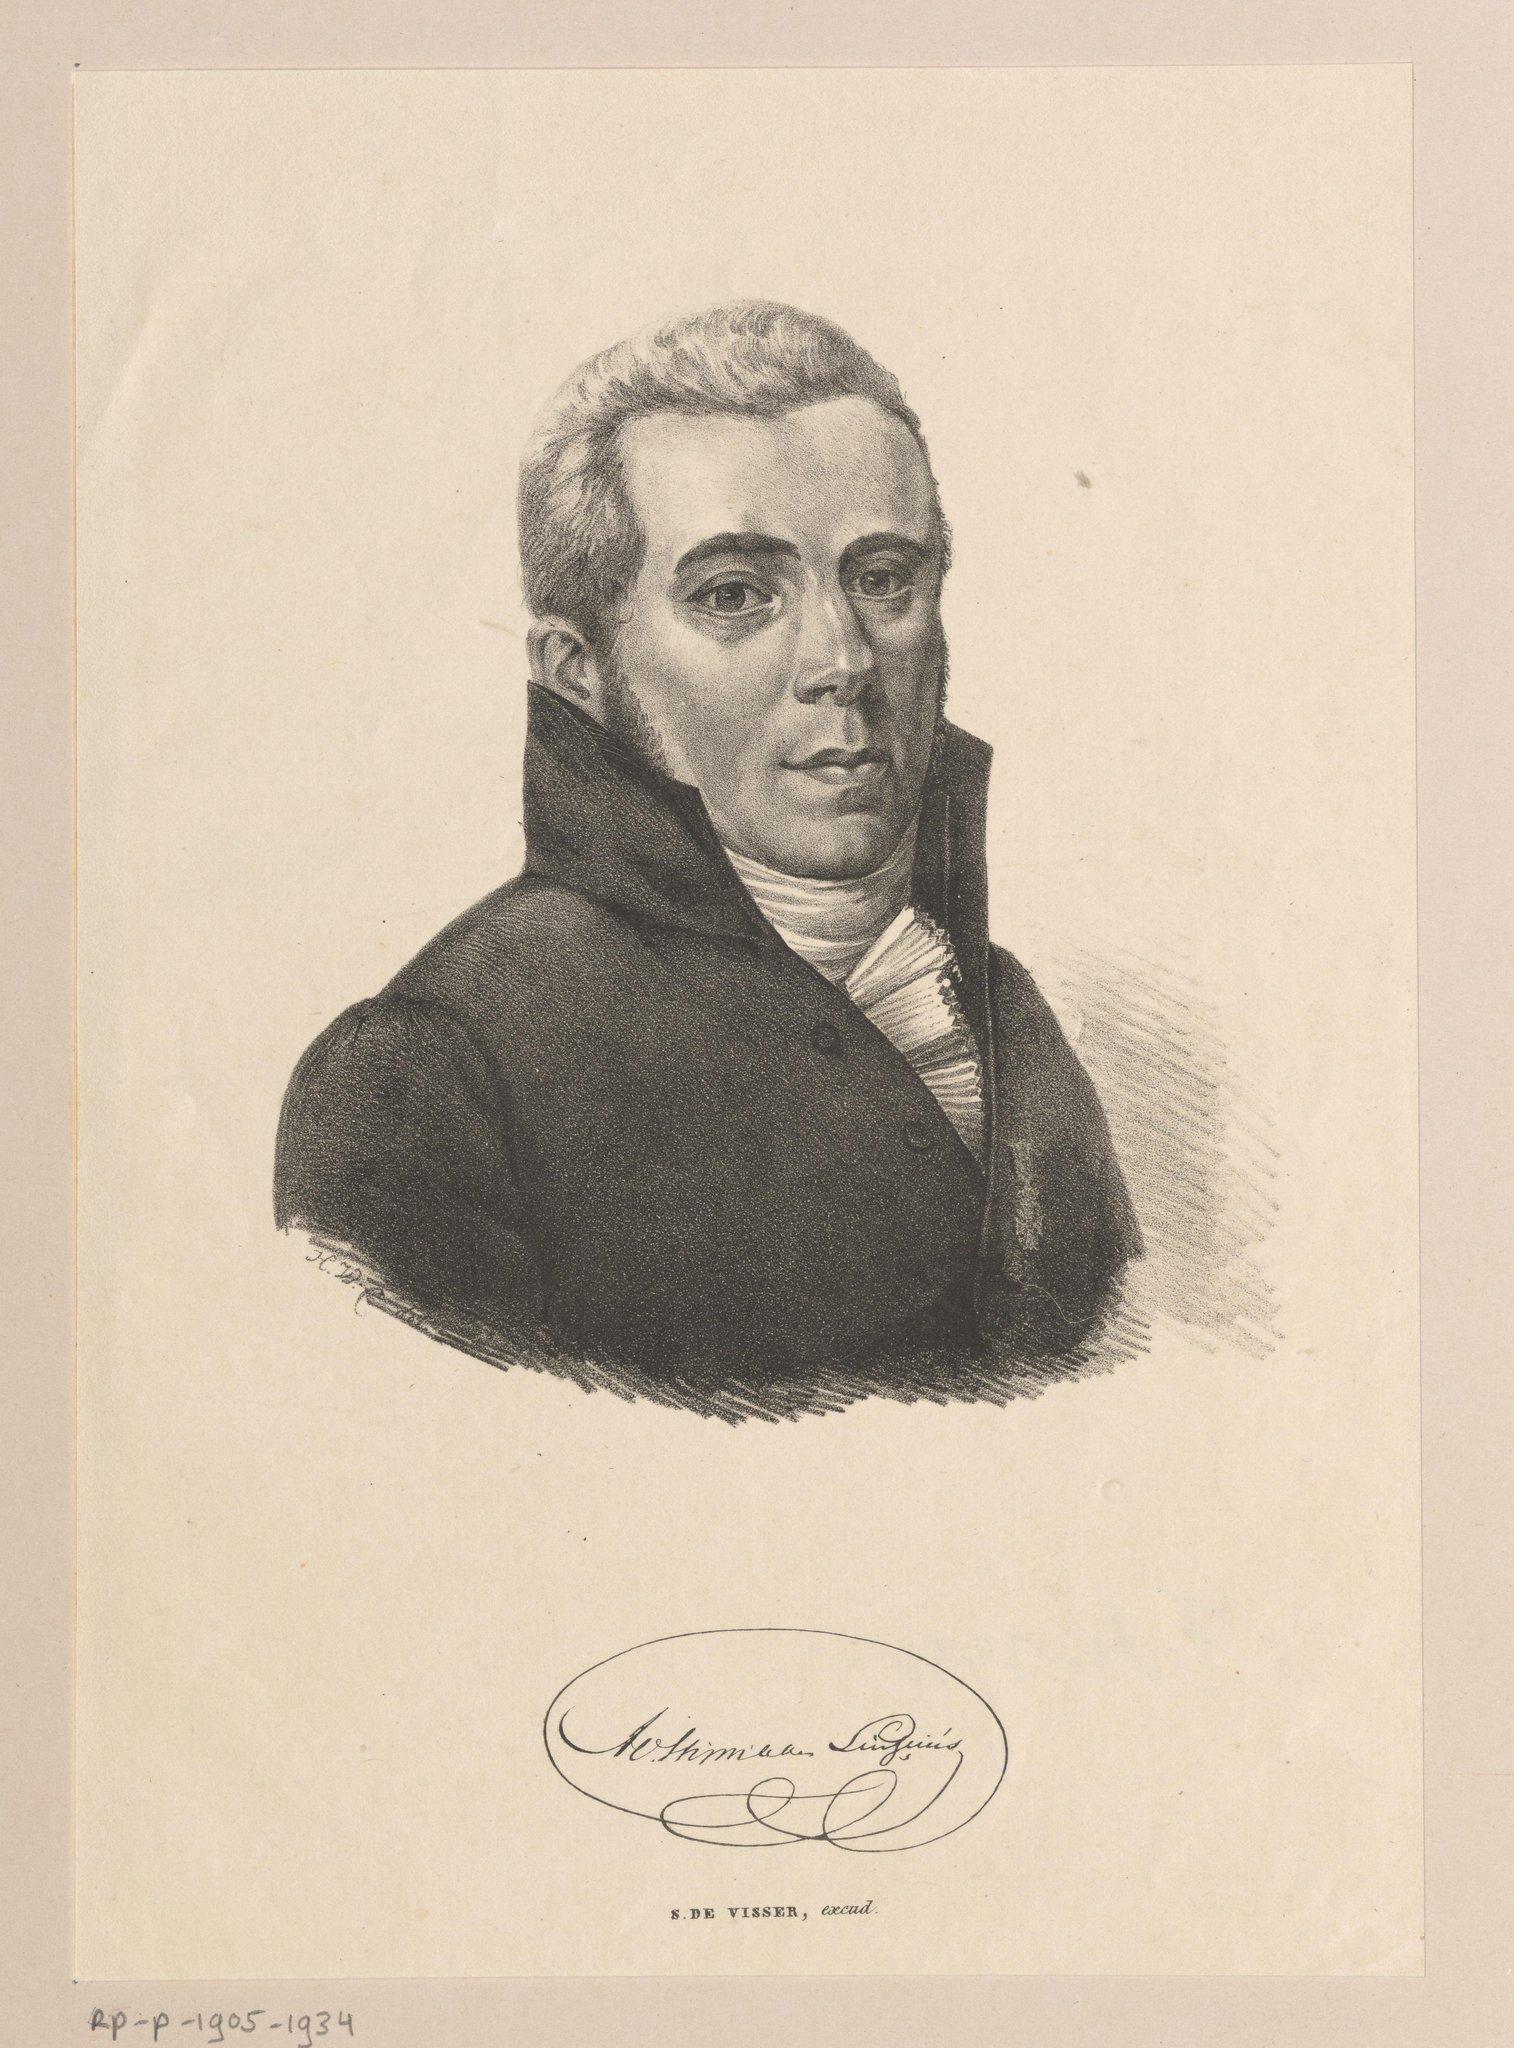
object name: print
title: Portret van Abraham van Stipriaan Luïscius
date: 1829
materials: paper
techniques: lithograph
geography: the hague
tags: knighthood order, historical persons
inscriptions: collector's mark: Lugt 2228